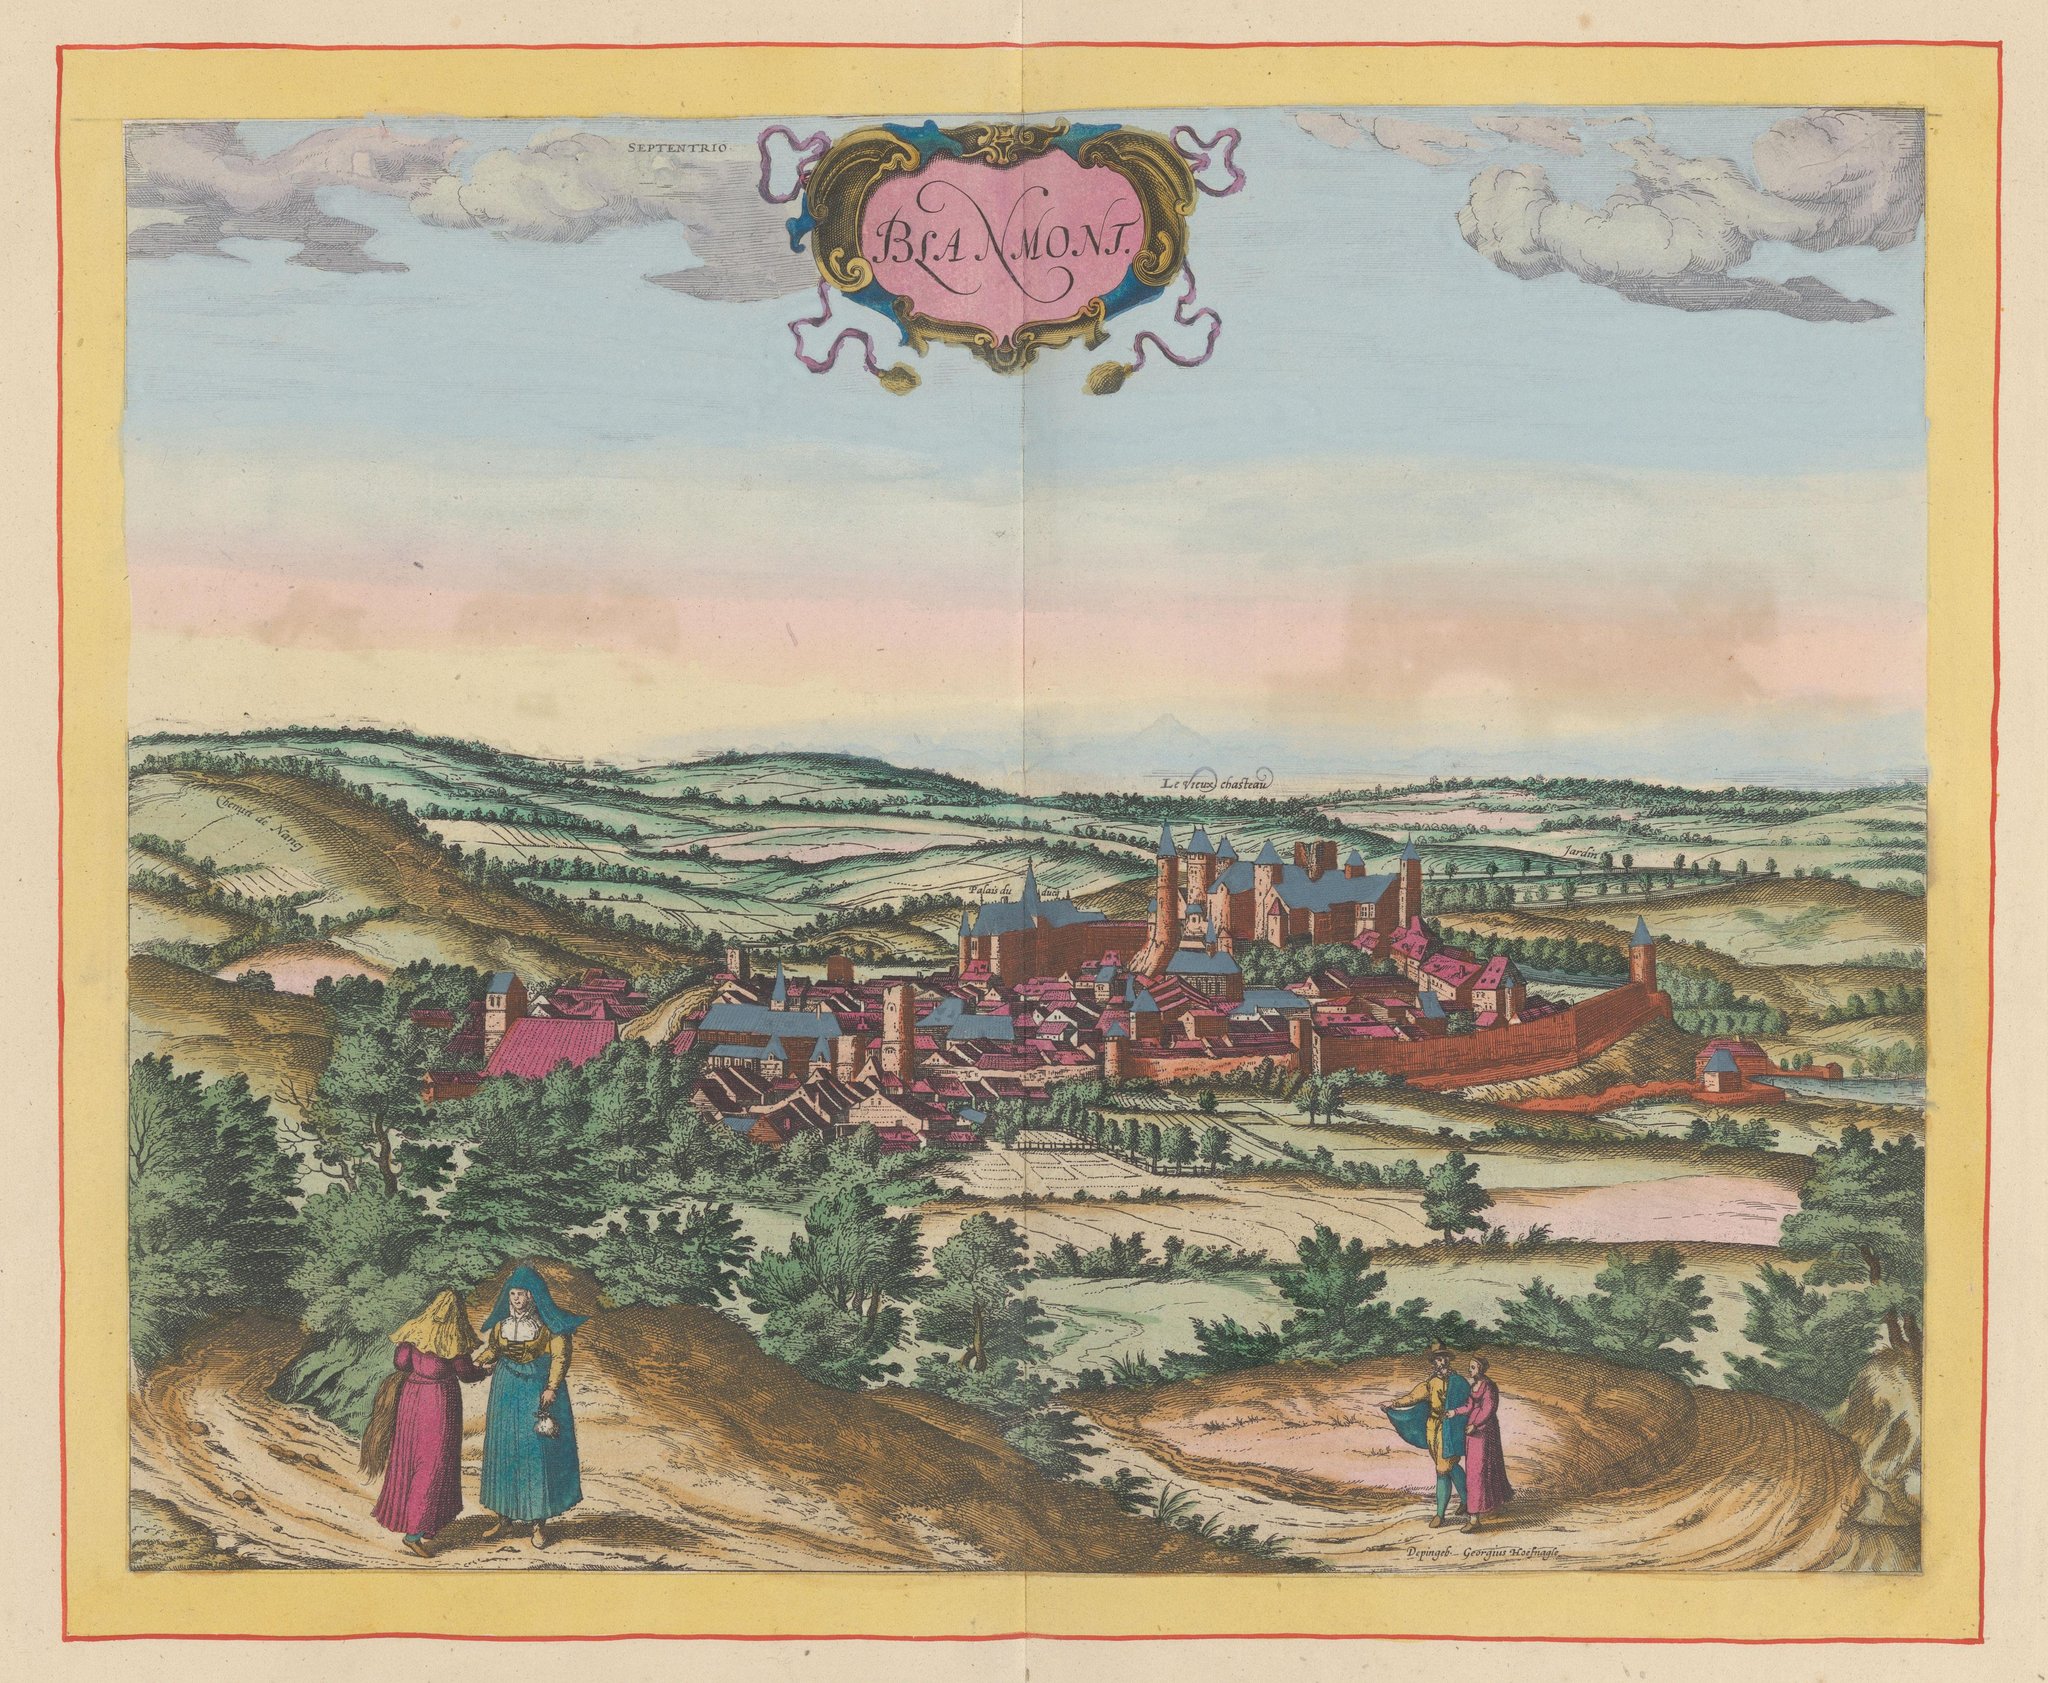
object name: album leaf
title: Gezicht op Blamont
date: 1657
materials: paper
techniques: engraving, etching, hand coloring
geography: the hague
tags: city-view in general; 'veduta'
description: Plattegrond gebruikt in diverse atlassen. Komt voor in: Theatrum exhibens celebriores Galliae et Helvetae urbes. Amsterdam: Johannes Janssonius, 1657, en in: Tooneel der vermaarste koop-steden. Amsterdam: Erven Johannes Janssonius van Waesberge, 1682.